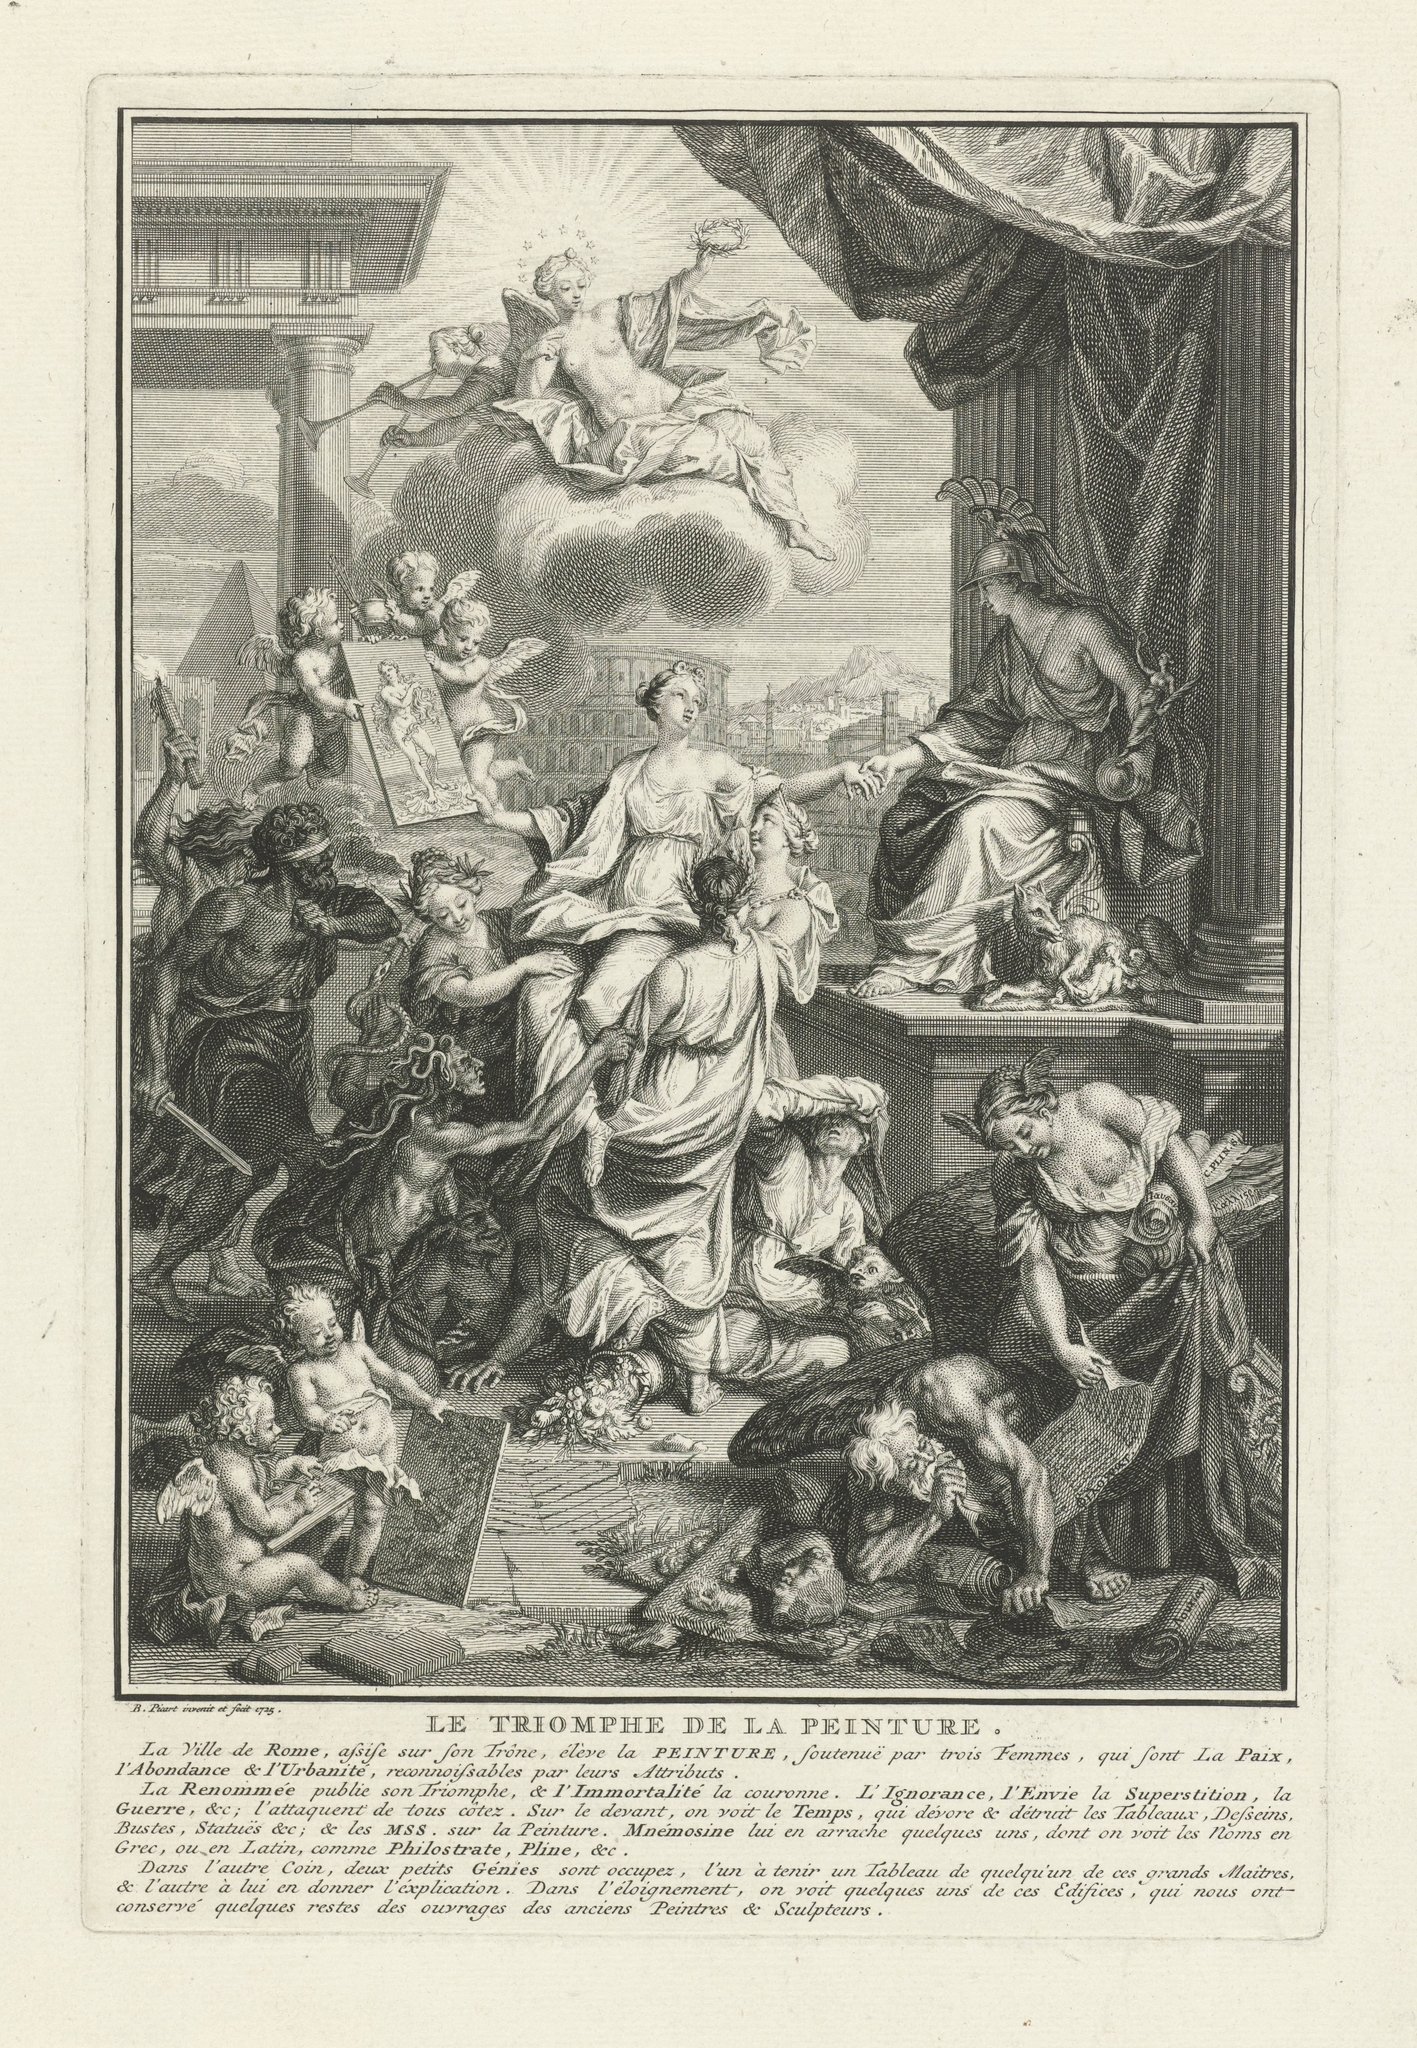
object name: titelblad, titelpagina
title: Titelpagina voor: Plinius, Histoire de la peinture ancienne (...), 1725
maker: bernard picart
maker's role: draughtsman, print maker, publisher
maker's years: 1673-1733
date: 1725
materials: paper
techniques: engraving, etching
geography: amsterdam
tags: mnemosyne, 'pictura', symbolic representations, allegories and emblems ~ painting; 'pittura' (ripa), symbols, allegories of peace, 'pax'; 'pace' (ripa), personification of a city, town-patron(ess), triumphs (allegorical and symbolic), eternity, 'aeternitas'; 'eternità','eternità o perpetuità' (ripa), abundance; 'abondanza', 'abondanza maritima' (ripa), father time, man with wings and scythe, rome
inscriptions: collector's mark: Lugt 240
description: Allegorische titelpagina met Vrede (Pax), Overvloed (Abundantia) en Urbaniteit die de Schilderkunst naar de personificatie van Rome dragen. Onwetendheid (Ignorantia), Afgunst (Invidia) en Bijgeloof (Idolatria) proberen hen tegen te houden. Rechts op de voorgrond Mnemosyne, de godin van het geheugen, die teksten uit de handen van Vader Tijd trekt. In de lucht op een wolk Eeuwigheid met een lauwerkrans in de hand. Op de achtergrond een gezicht op Rome. In de marge een negenregelig onderschrift in het Frans.